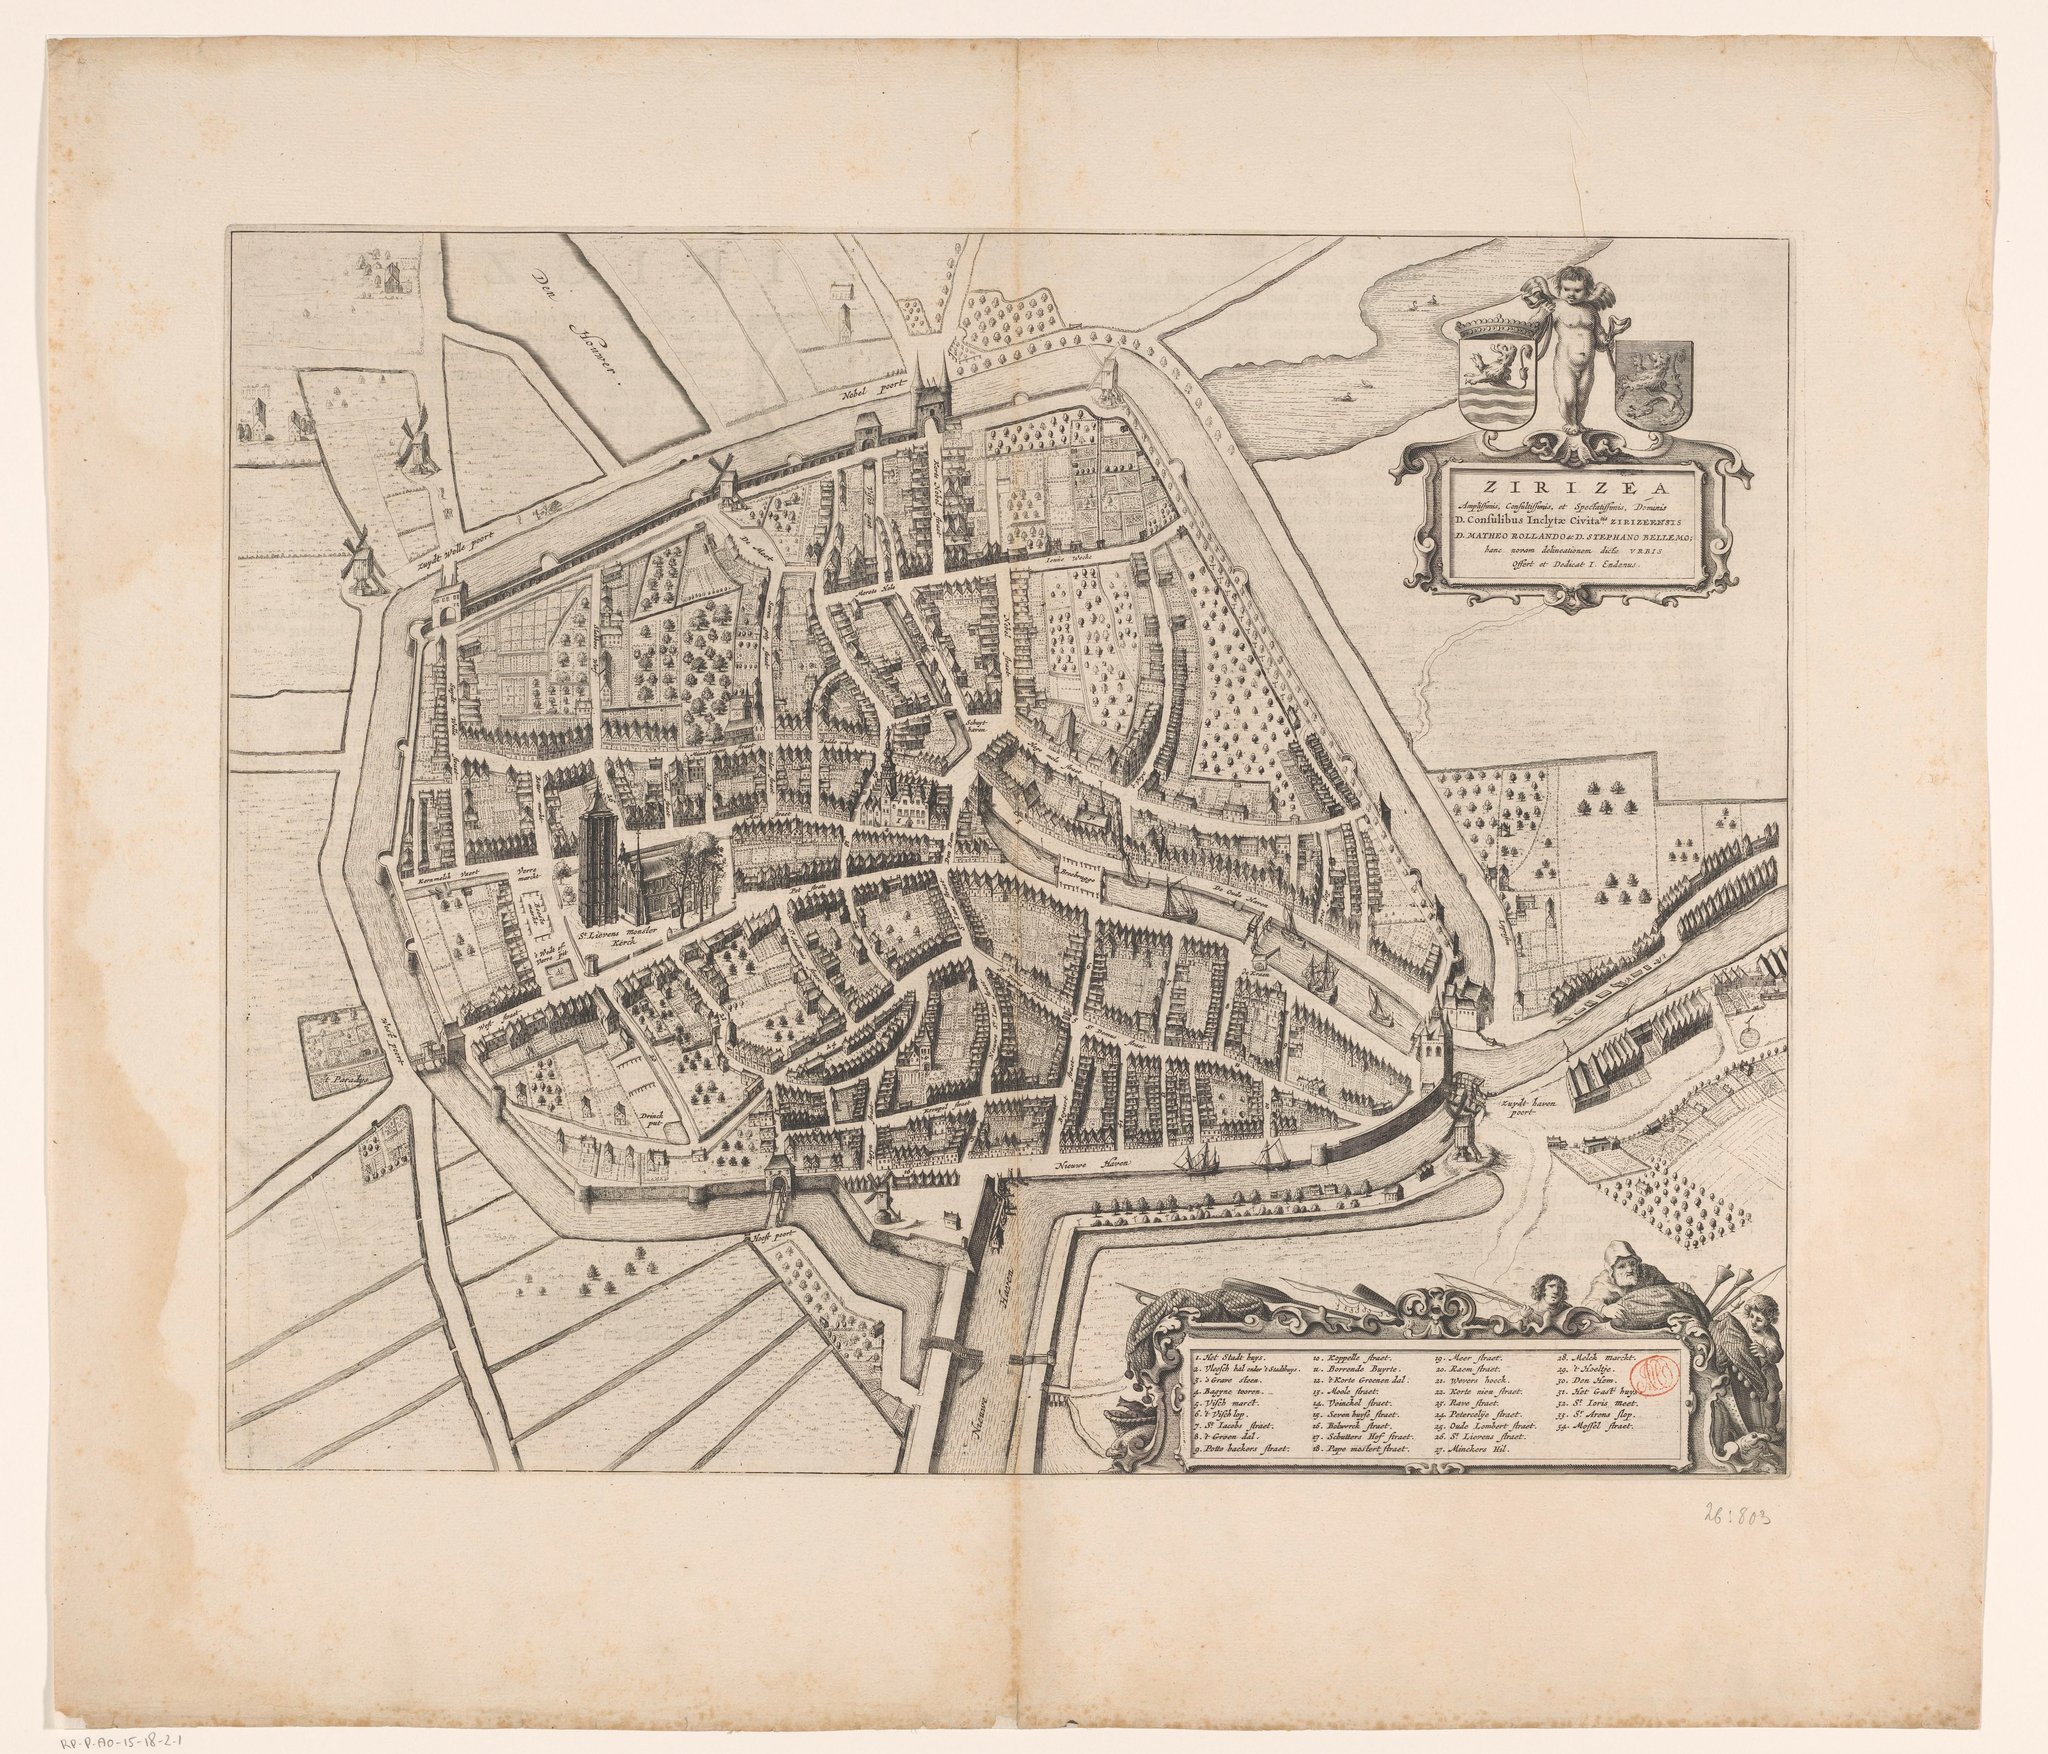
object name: print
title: Plattegrond van Zierikzee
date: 1652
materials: paper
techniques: engraving, etching, letterpress printing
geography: amsterdam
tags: coat of arms (as symbol of the state, etc.) (+ city; municipal), maps of cities, coat of arms (as symbol of the state, etc.) (+ province; provincial)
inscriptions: collector's mark: Lugt 195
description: Plattegrond in vogelvluchtperspectief. Rechtsboven de titelcartouche met het wapen van Zeeland en dat van Zierikzee. Rechtsonder een cartouche met de legenda 1-34. Op verso Nederlandse tekst.